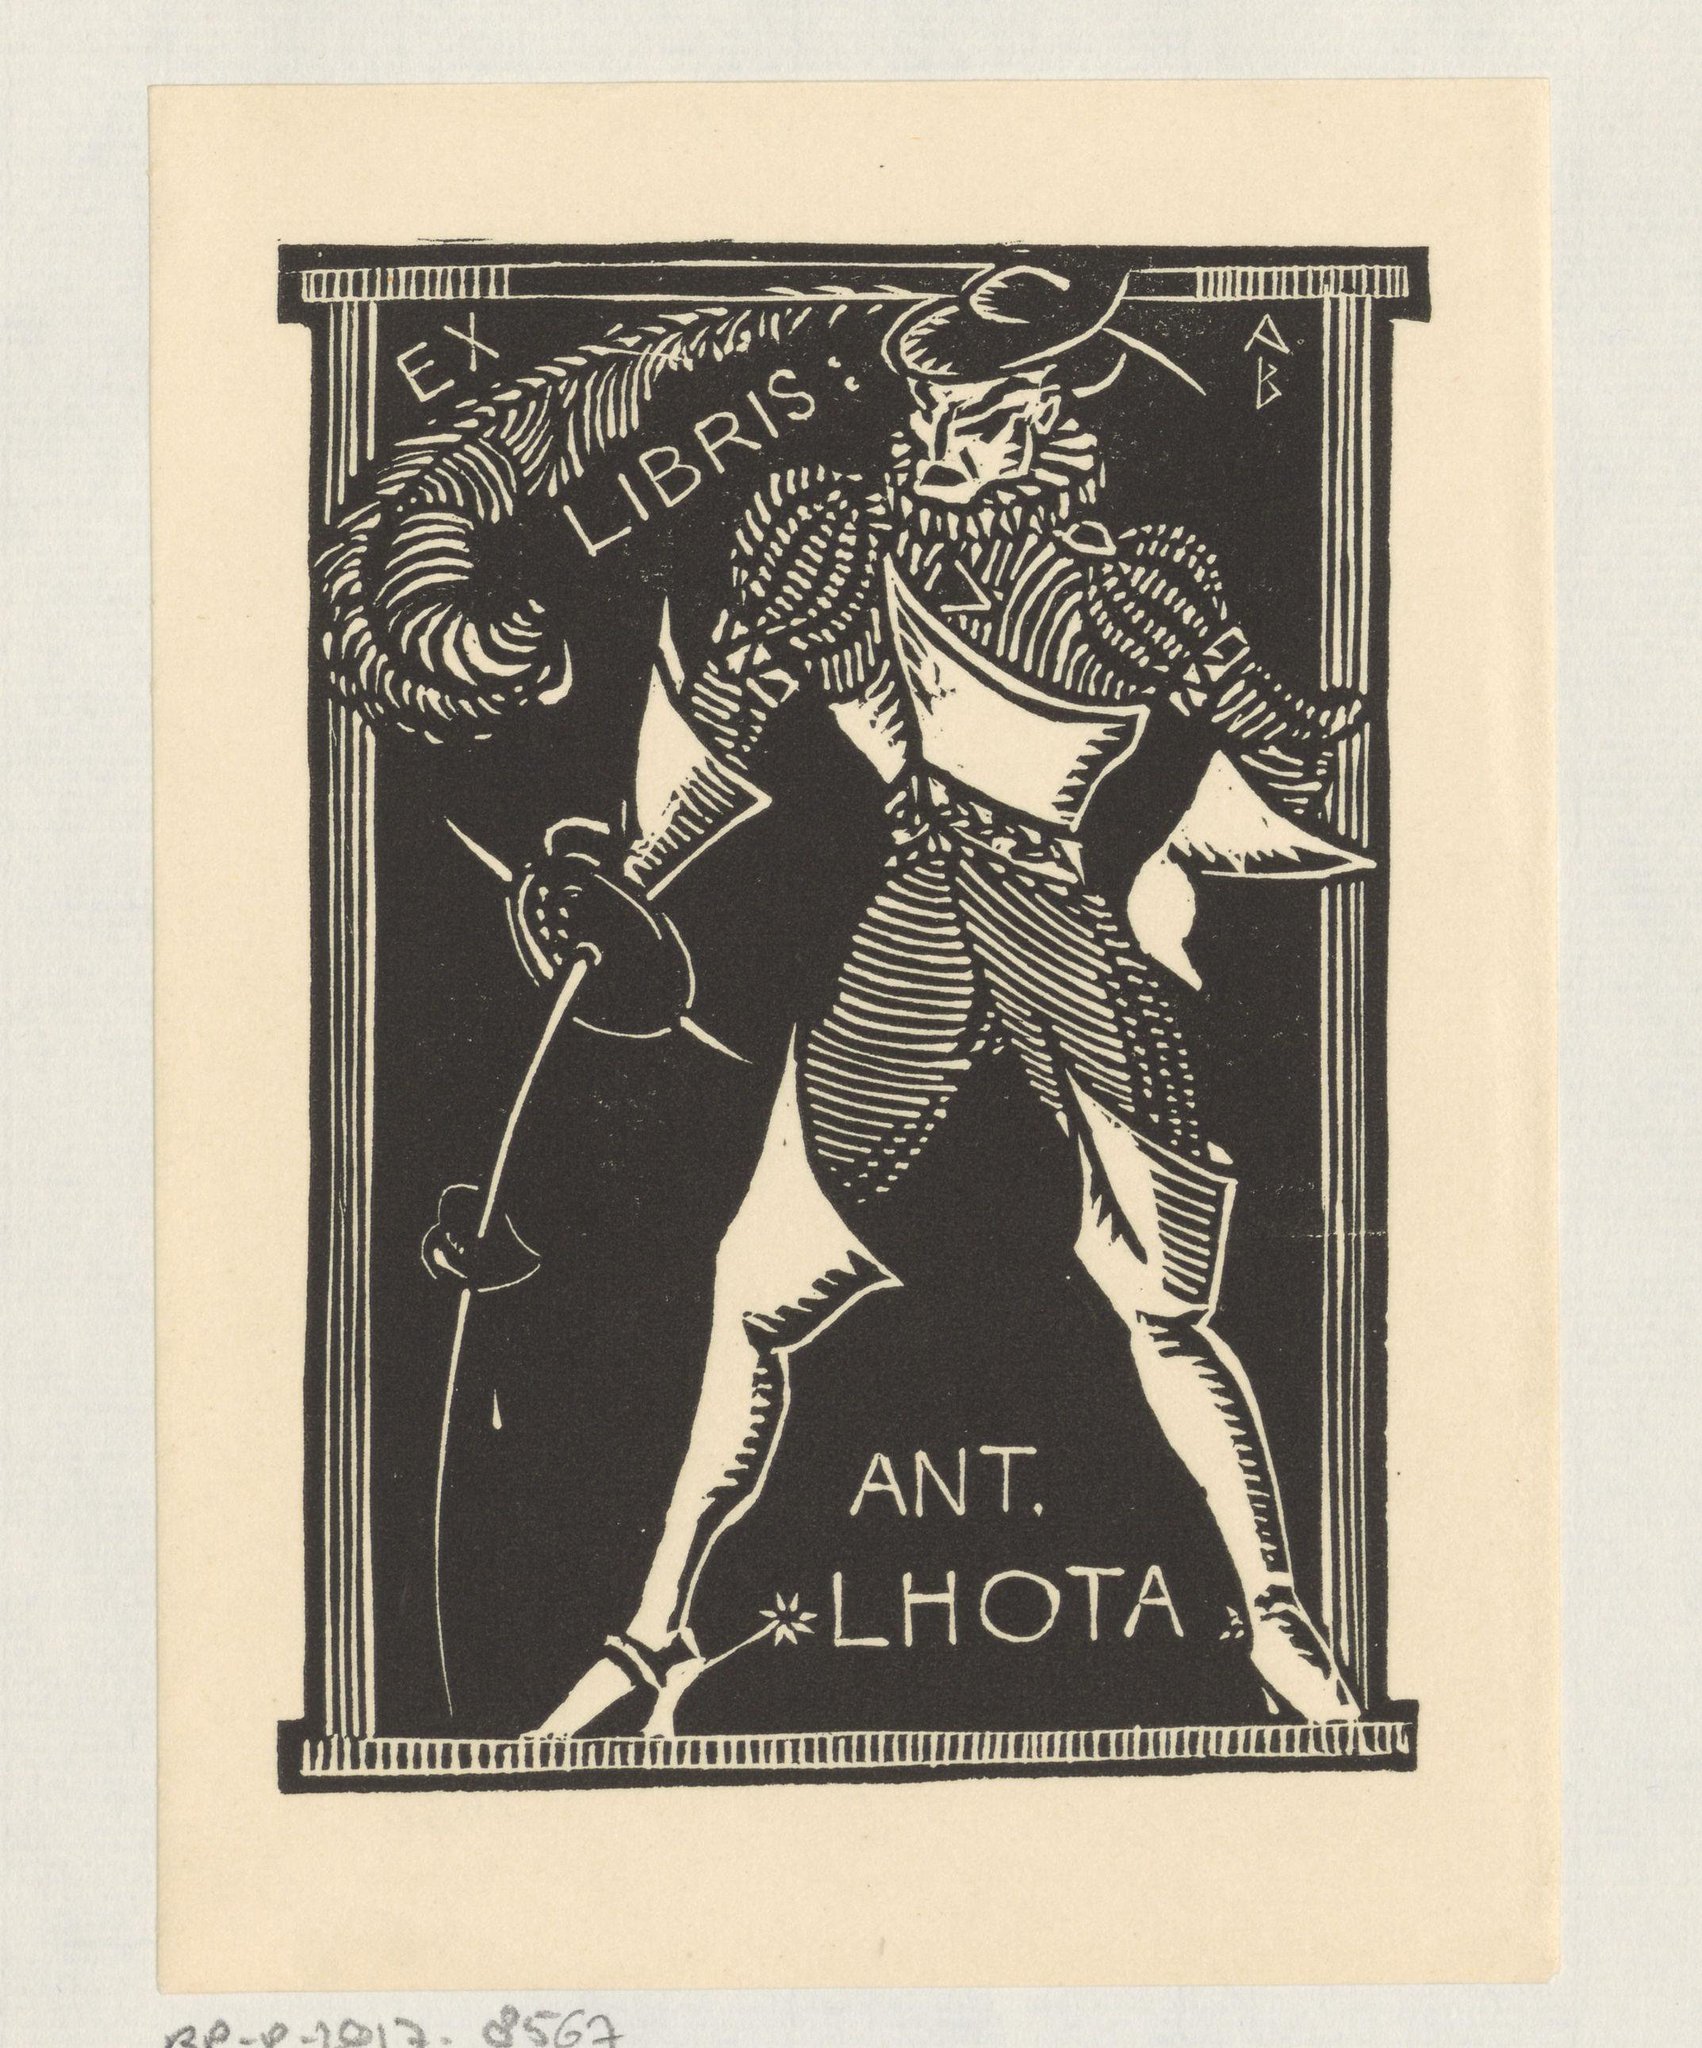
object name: bookplate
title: Ex libris van Ant. Lhota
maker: antonín burka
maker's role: painter, print maker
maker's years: 1896-1947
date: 1922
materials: paper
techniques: woodcut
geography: czech republic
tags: sabre (~ fencing), heart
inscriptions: inscription: ‘Ant. Burka/ 1922’